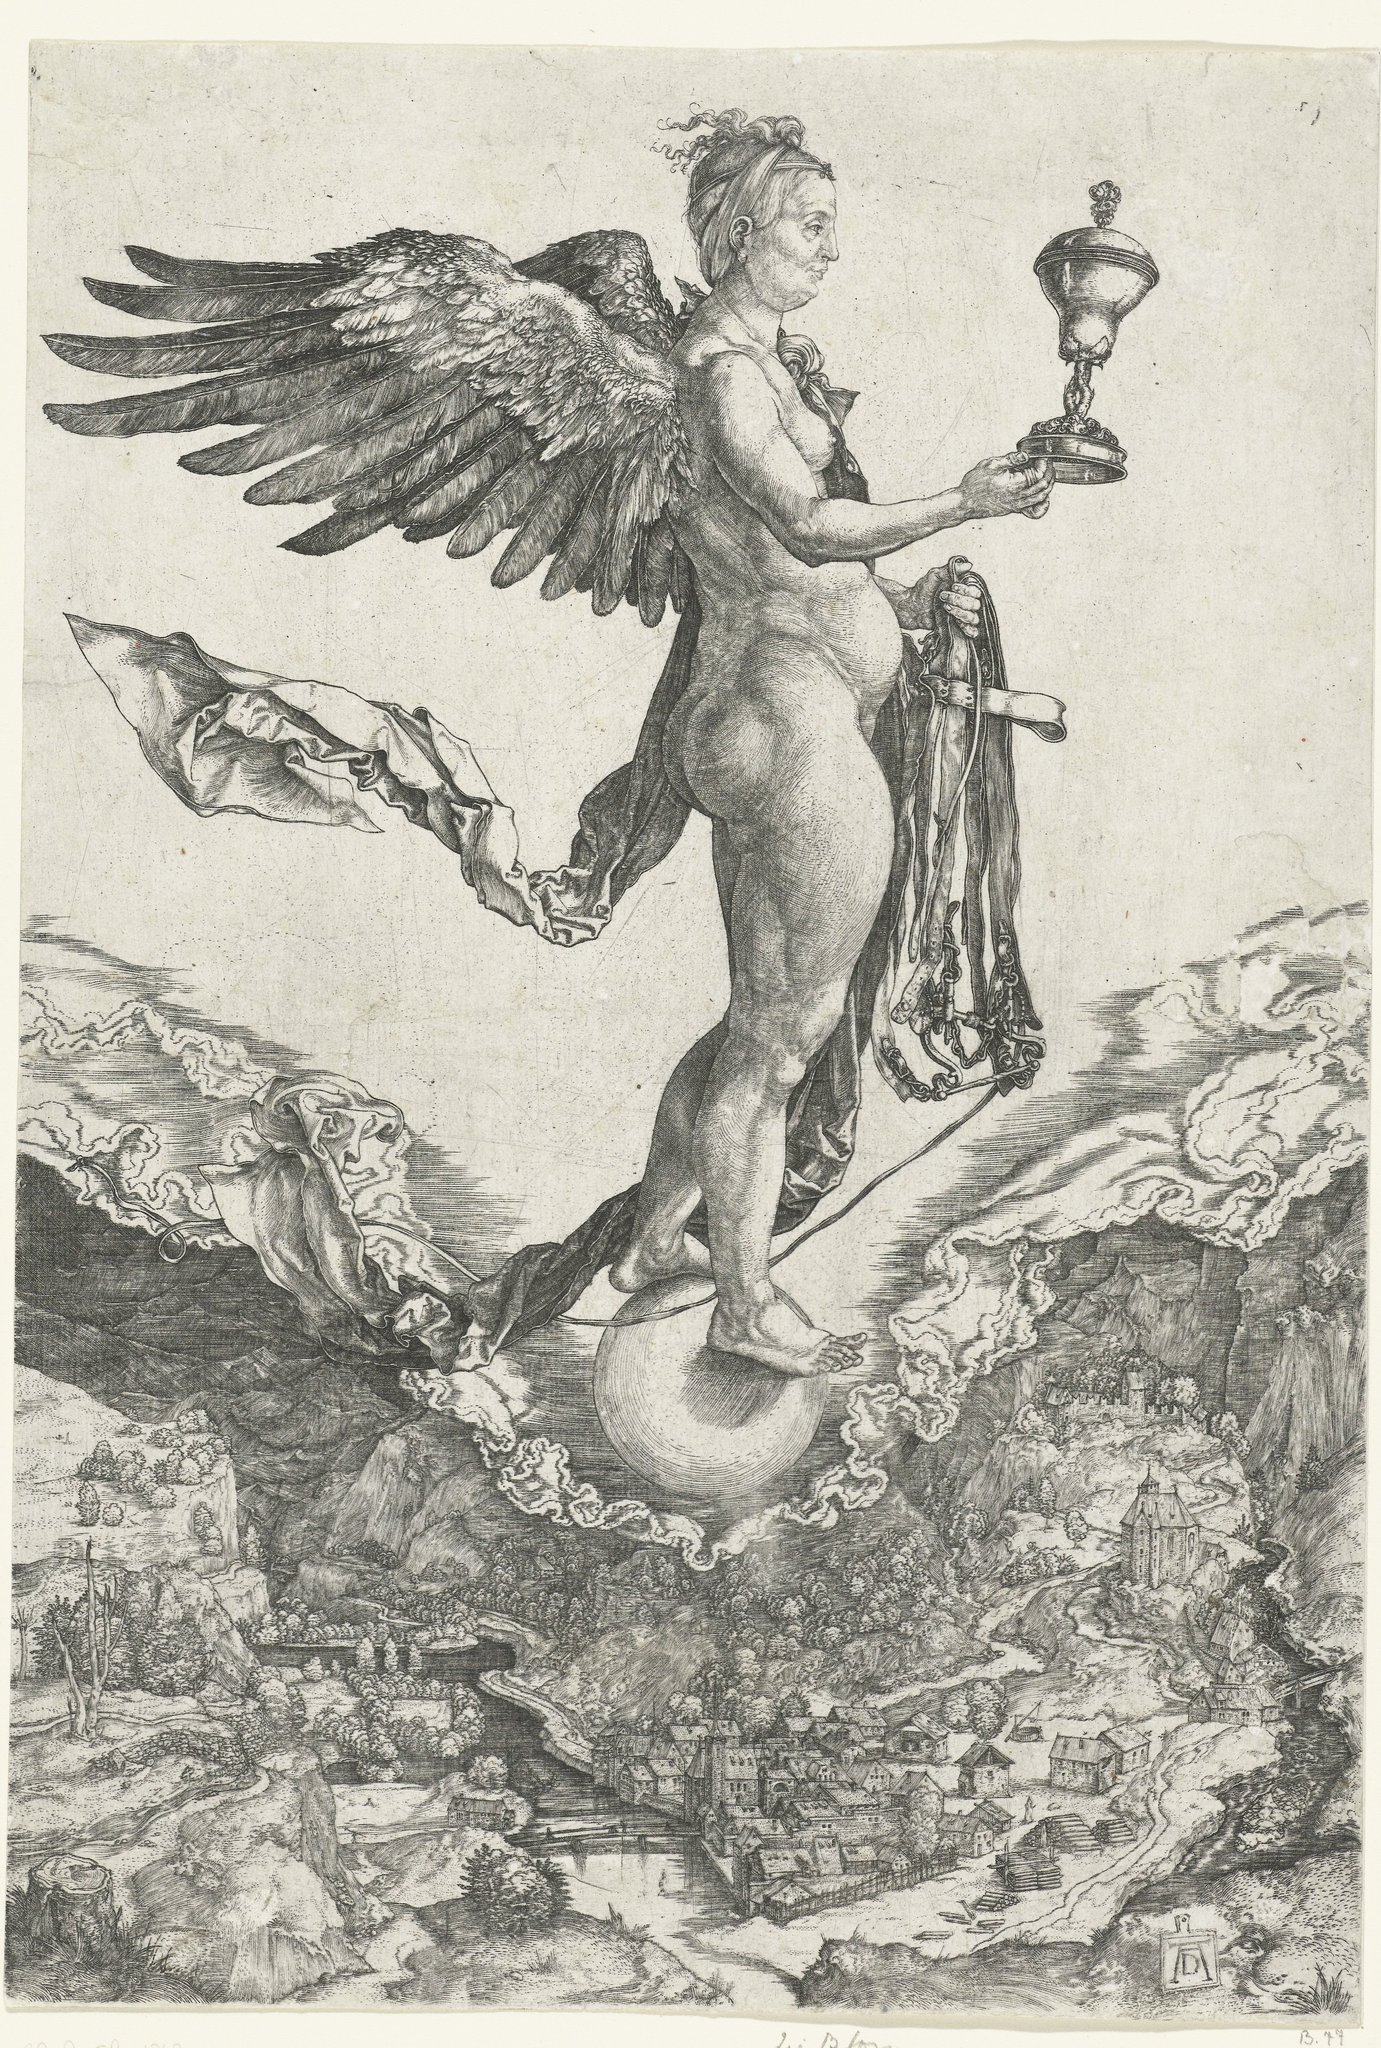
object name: print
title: Nemesis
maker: albrecht dürer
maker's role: draughtsman, painter, print maker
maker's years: 1471-1528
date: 1499-1503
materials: paper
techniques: engraving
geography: nuremberg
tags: nemesis (adrastea), luck, fortune, lot; 'fato', 'fortuna', 'fortuna aurea', 'fortuna buona', 'fortuna pacifica overo clemente', 'sorte' (ripa)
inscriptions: collector's mark: Lugt 2228a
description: Een gevleugelde vrouw met een beker in de ene hand en een breidel in de andere hand, staande op een bol, zwevend boven een rivierdal met een dorp.